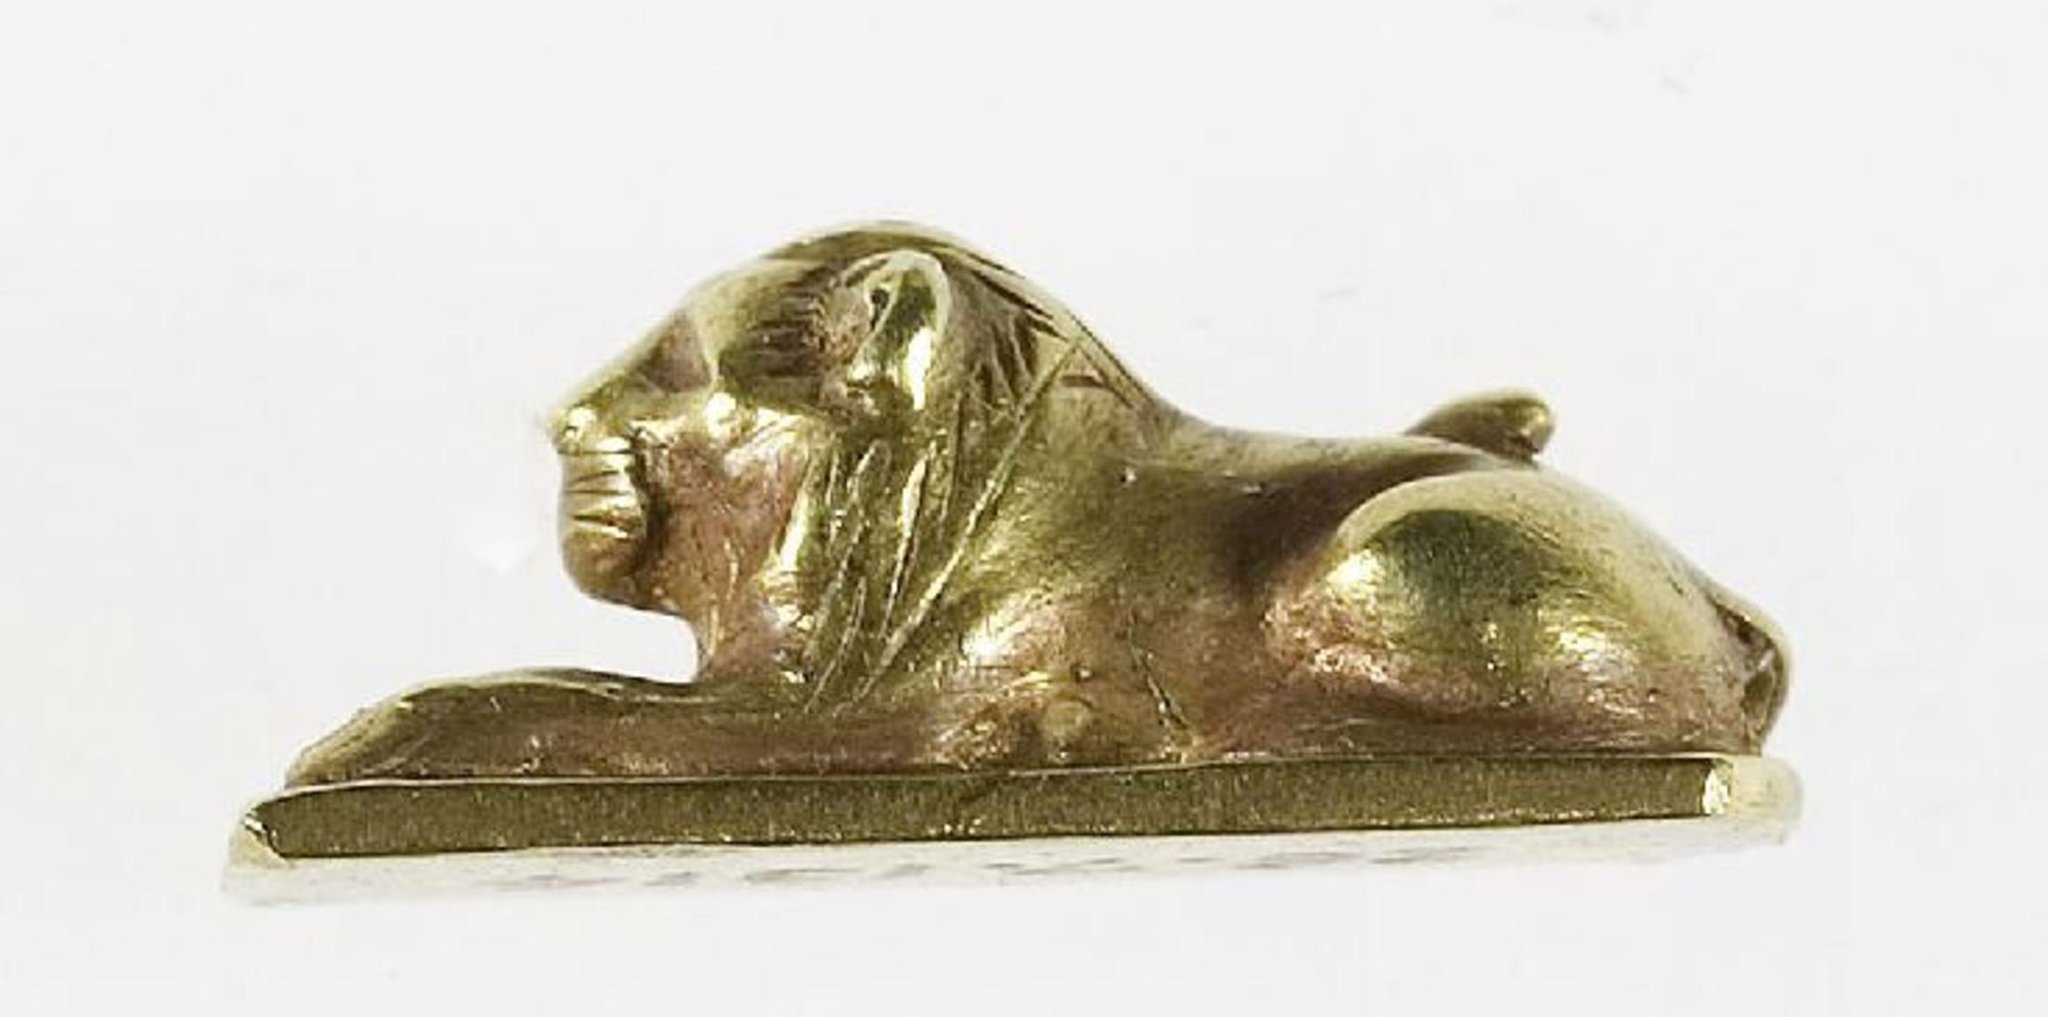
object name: ornament, lion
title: Recumbent lion from a bracelet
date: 1878-1805 BCE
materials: gold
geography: memphite region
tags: lions